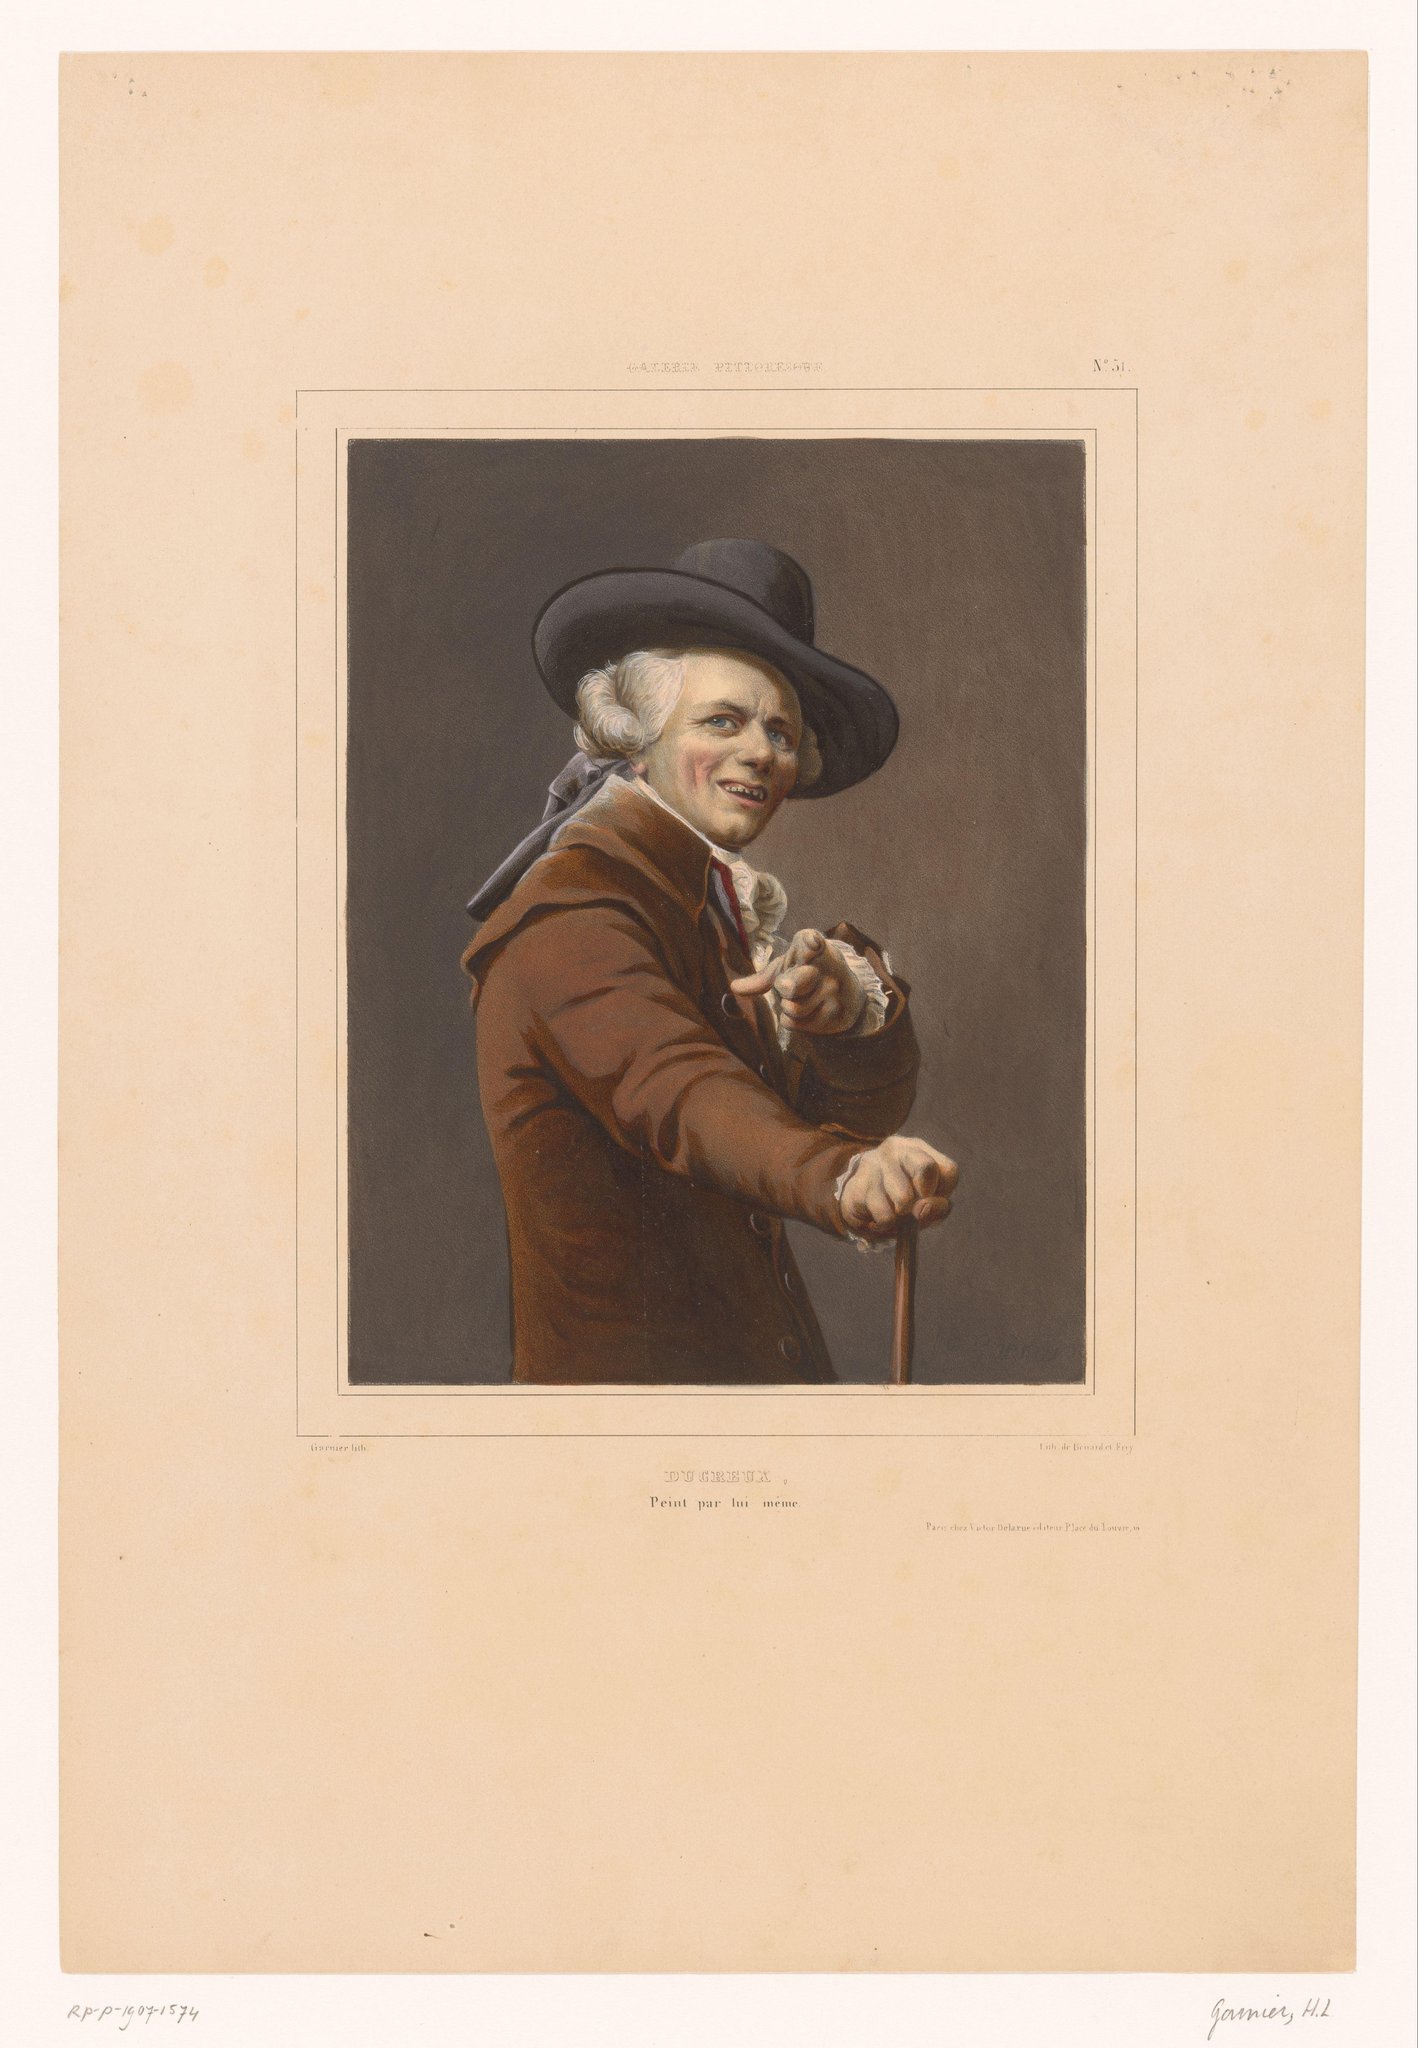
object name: print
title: Galerie pittoresque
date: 1837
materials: paper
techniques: hand coloring, lithograph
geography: paris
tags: painter, print maker, joseph ducreux, historical persons, portrait, self-portrait of painter, morphology of facial expression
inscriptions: collector's mark: Lugt 2228a